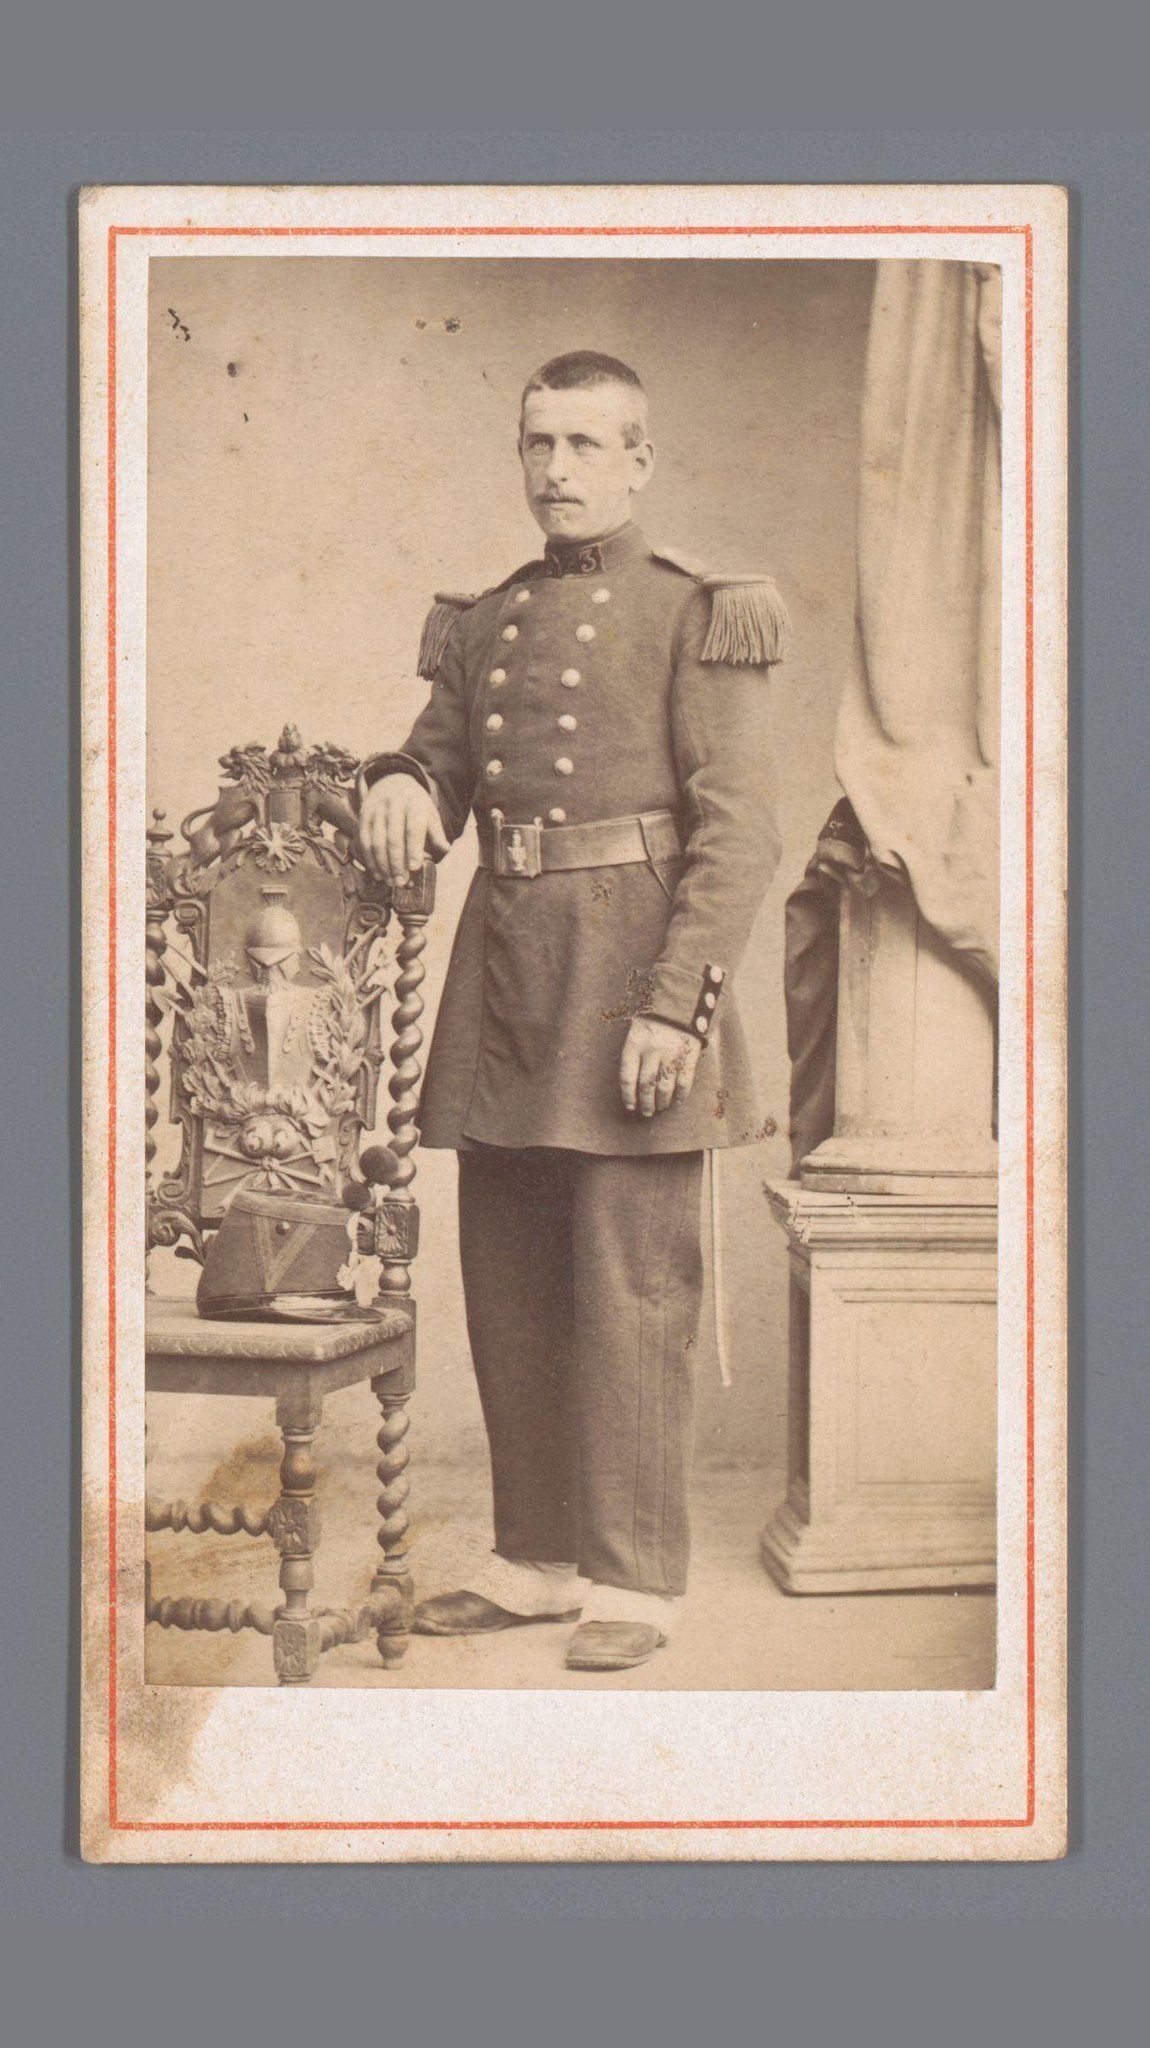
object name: carte de visite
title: Portret van een onbekende man in uniform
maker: Anonymous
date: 1855-1885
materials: cardboard, paper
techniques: albumen print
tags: adult man, anonymous historical person portrayed, (military) uniforms